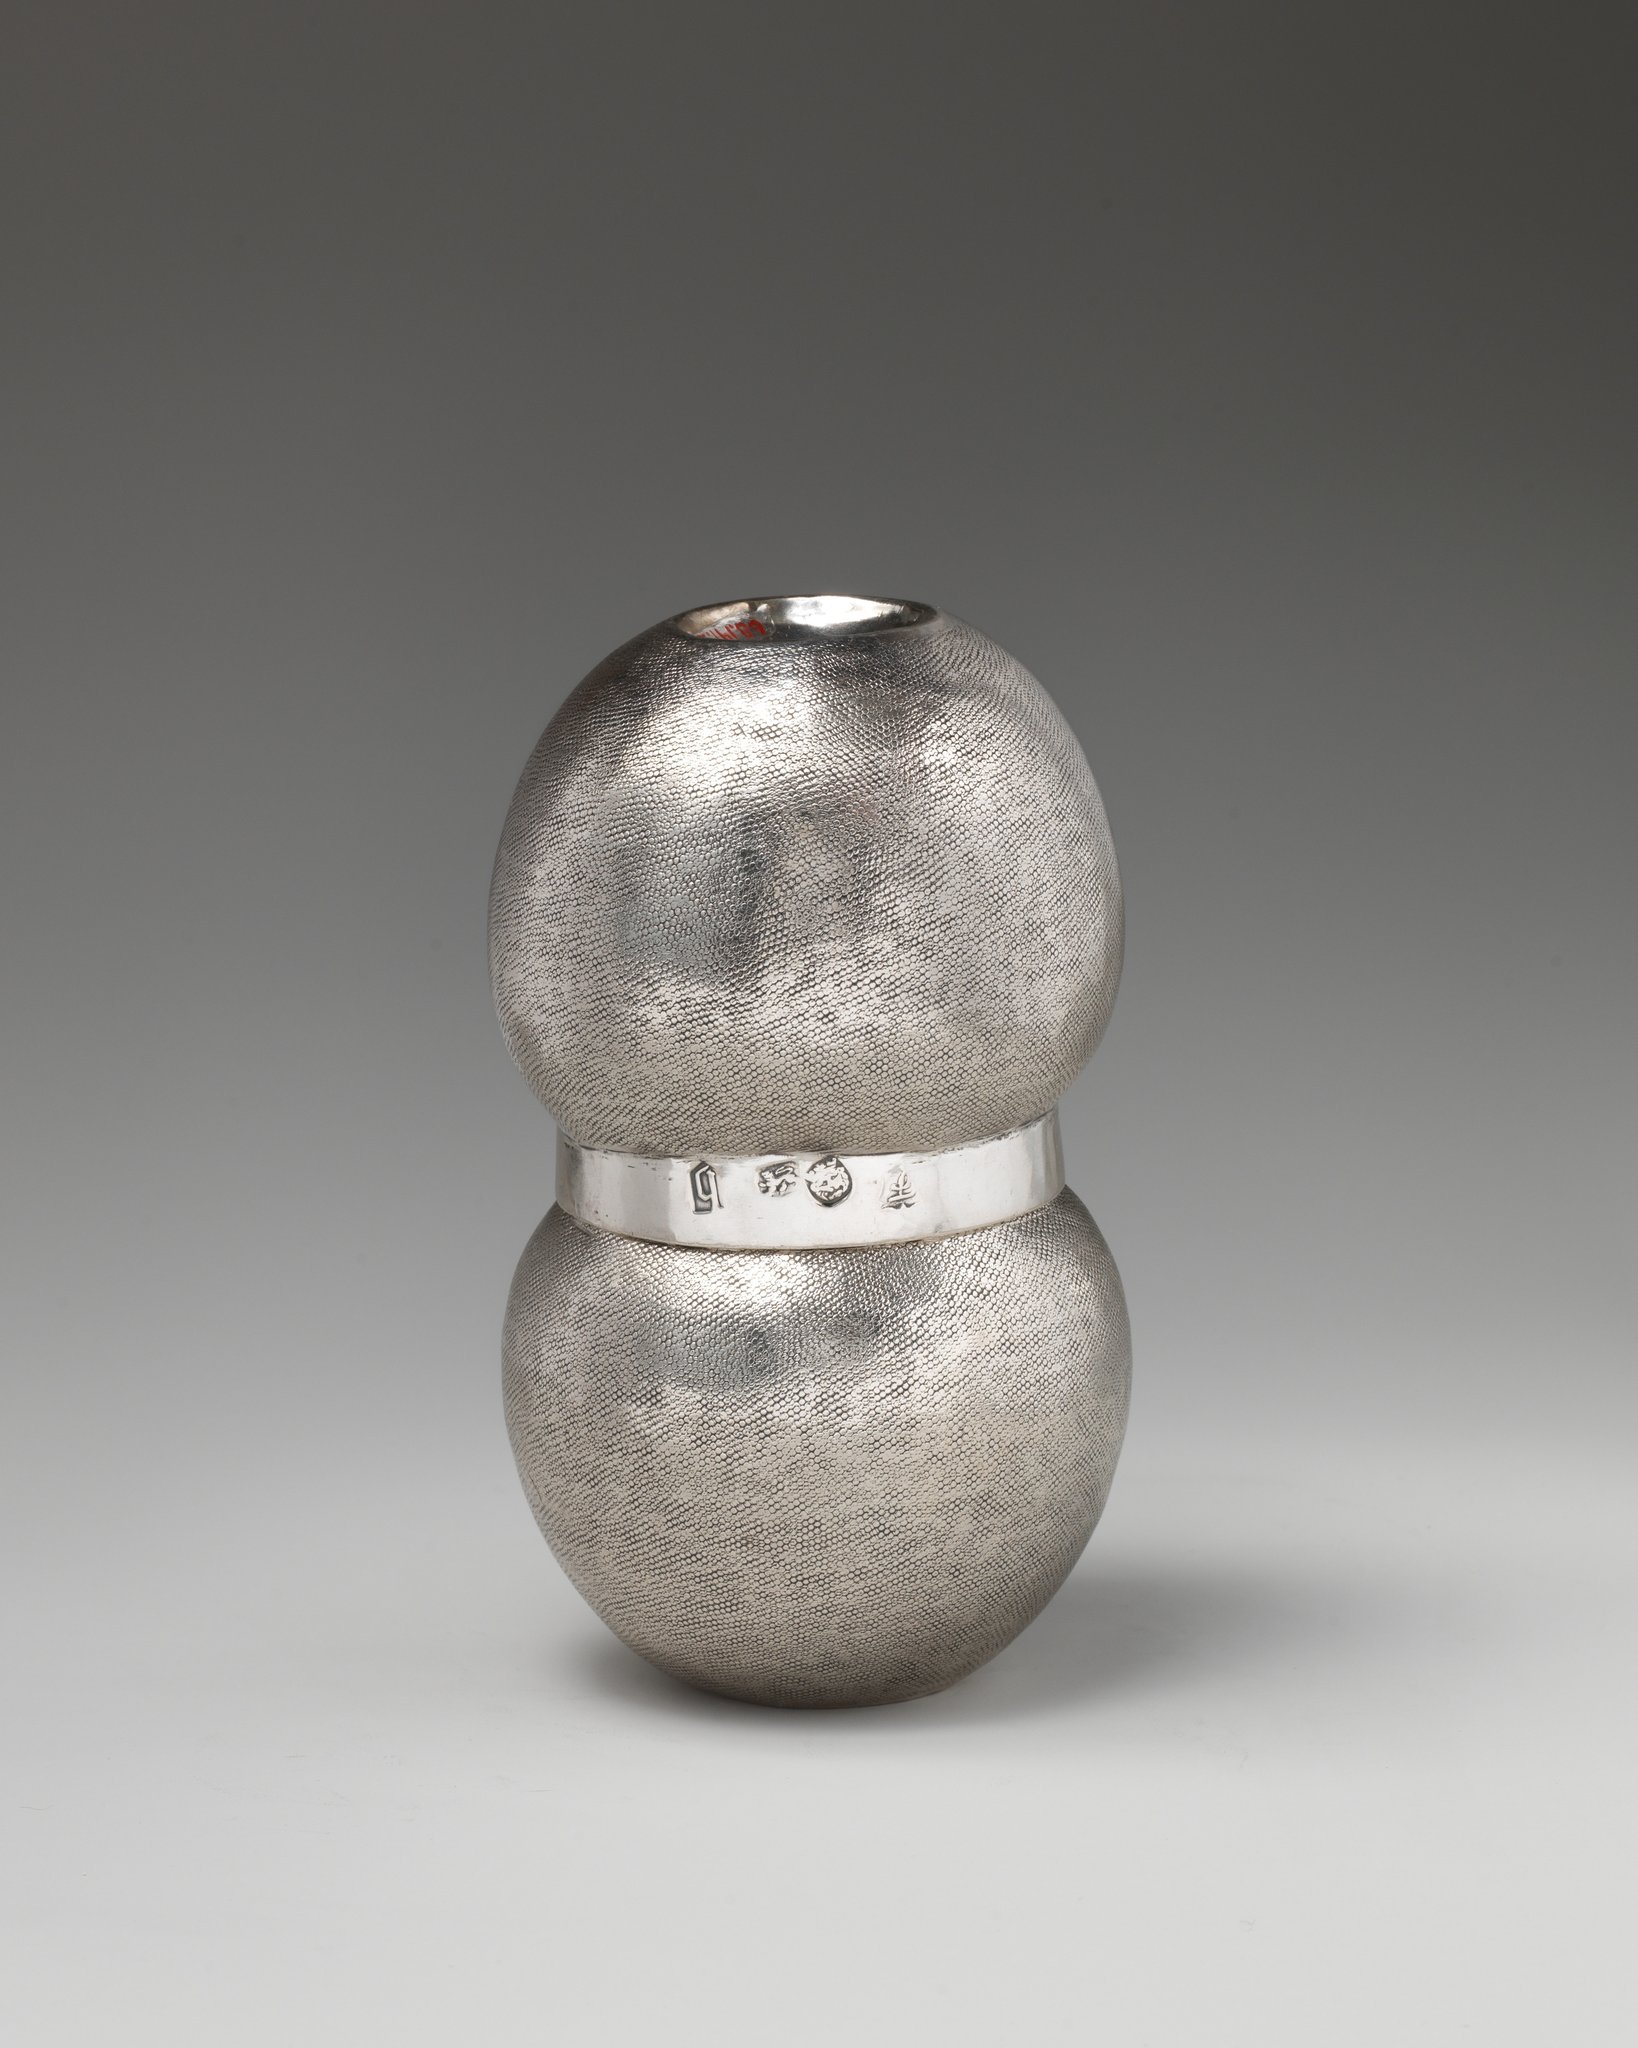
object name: double cup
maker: thomas cory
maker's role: maker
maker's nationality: british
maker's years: 1655-1689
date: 1685-1686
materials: silver